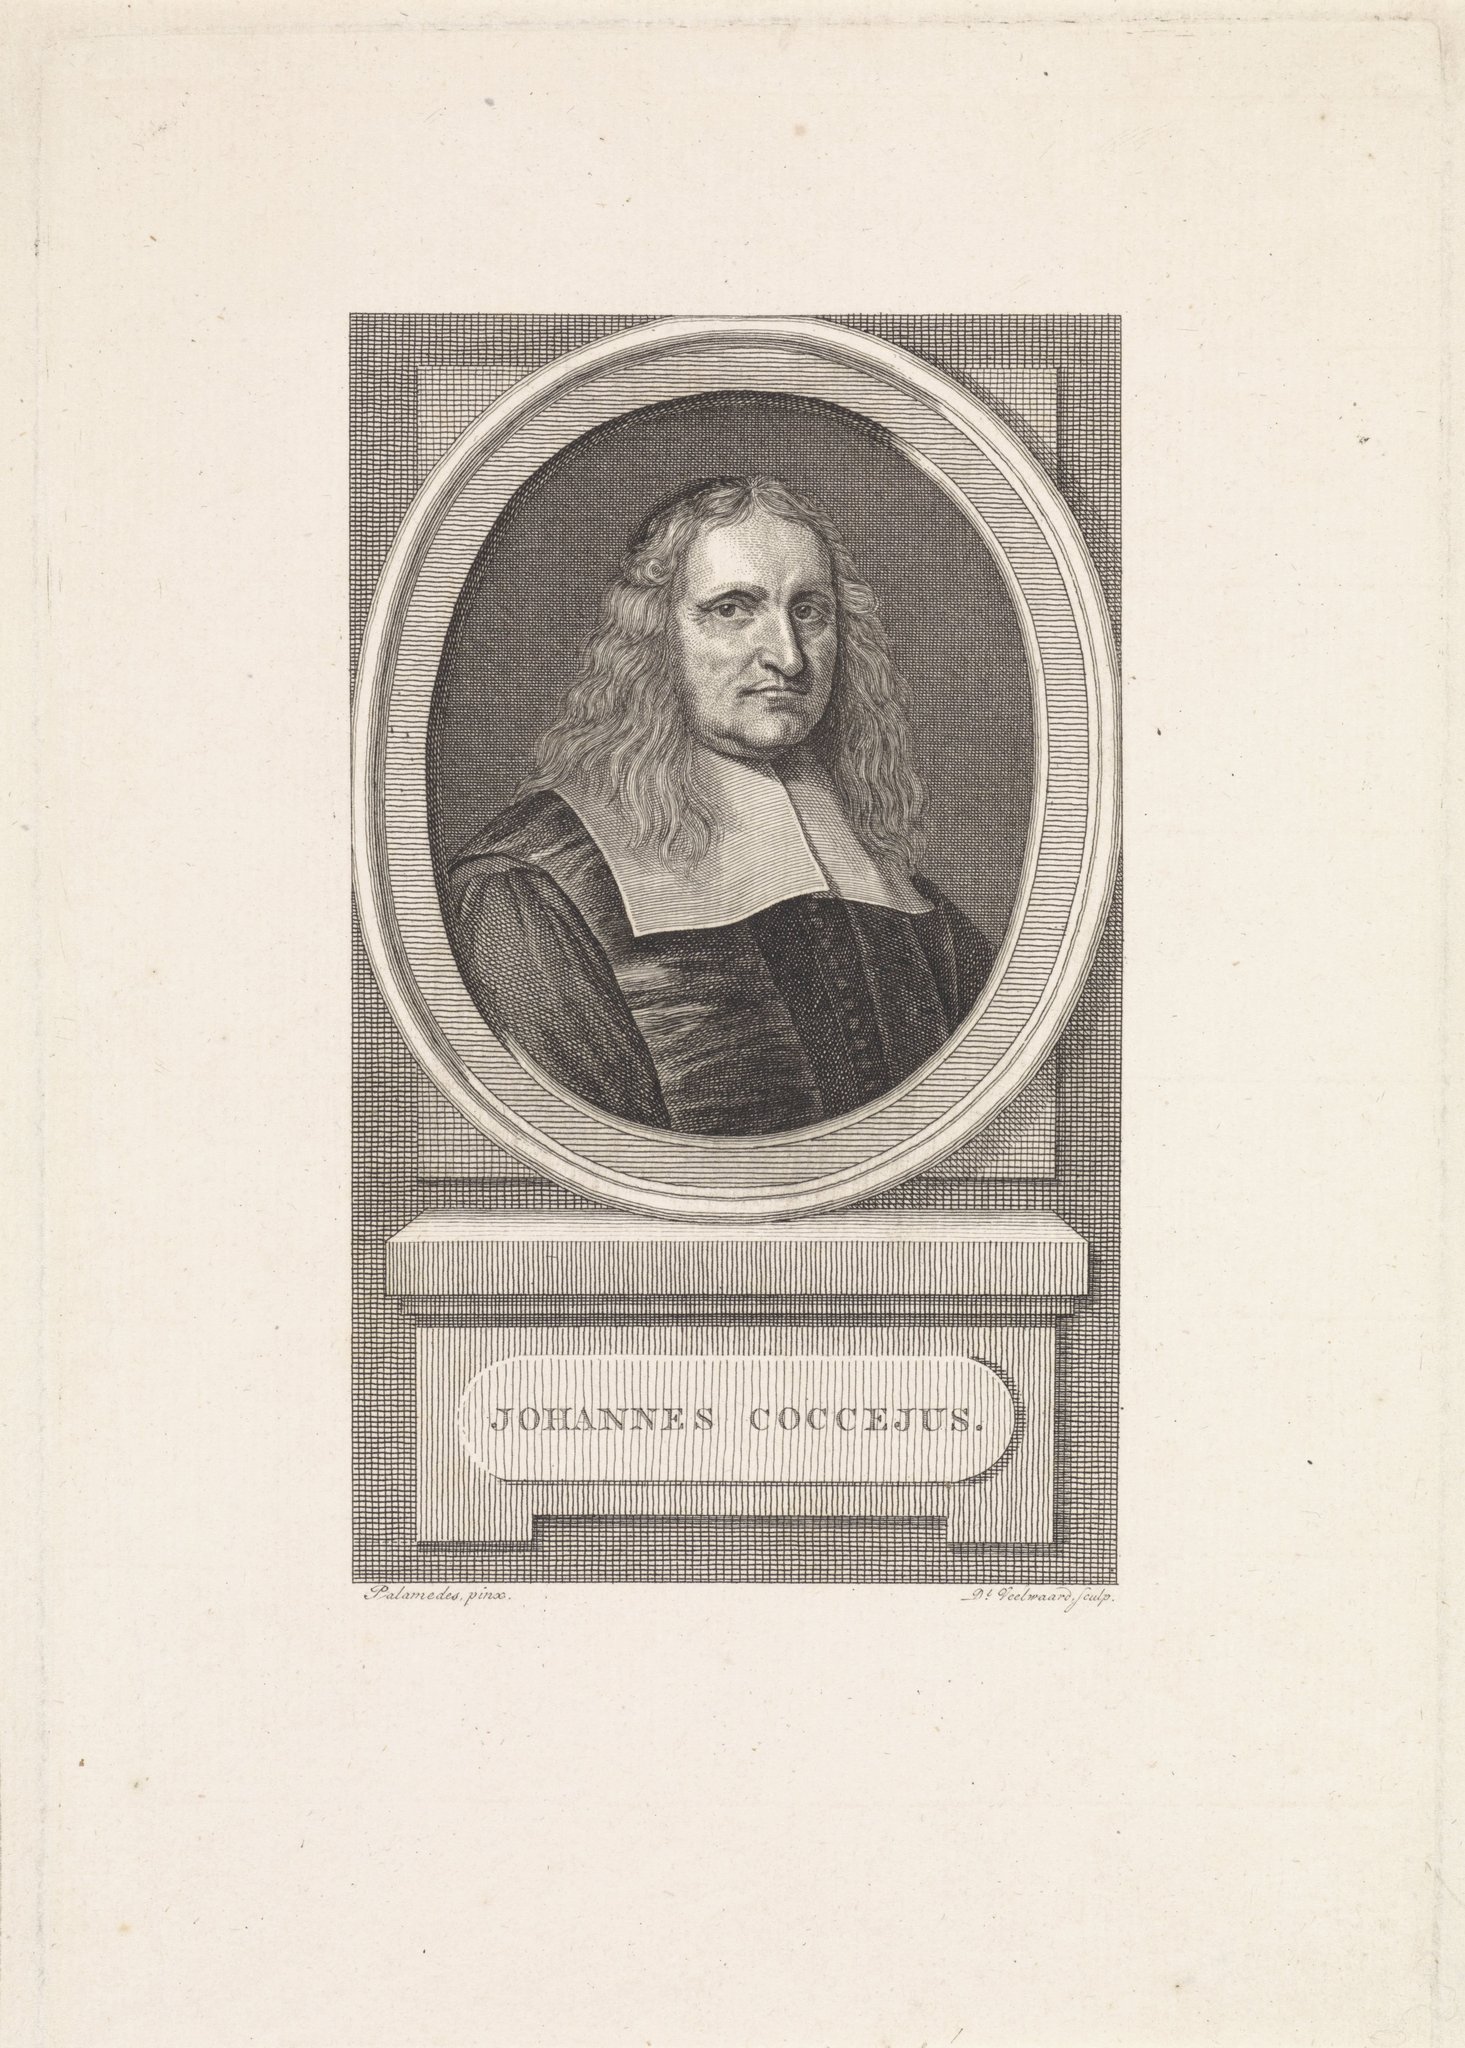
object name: print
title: Portret van de theoloog Johannes Cocceius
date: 1776-1851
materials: paper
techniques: engraving, etching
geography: amsterdam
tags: bremen, theoloog, hoogleraar, johannes cocceius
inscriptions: collector's mark: Lugt 2228